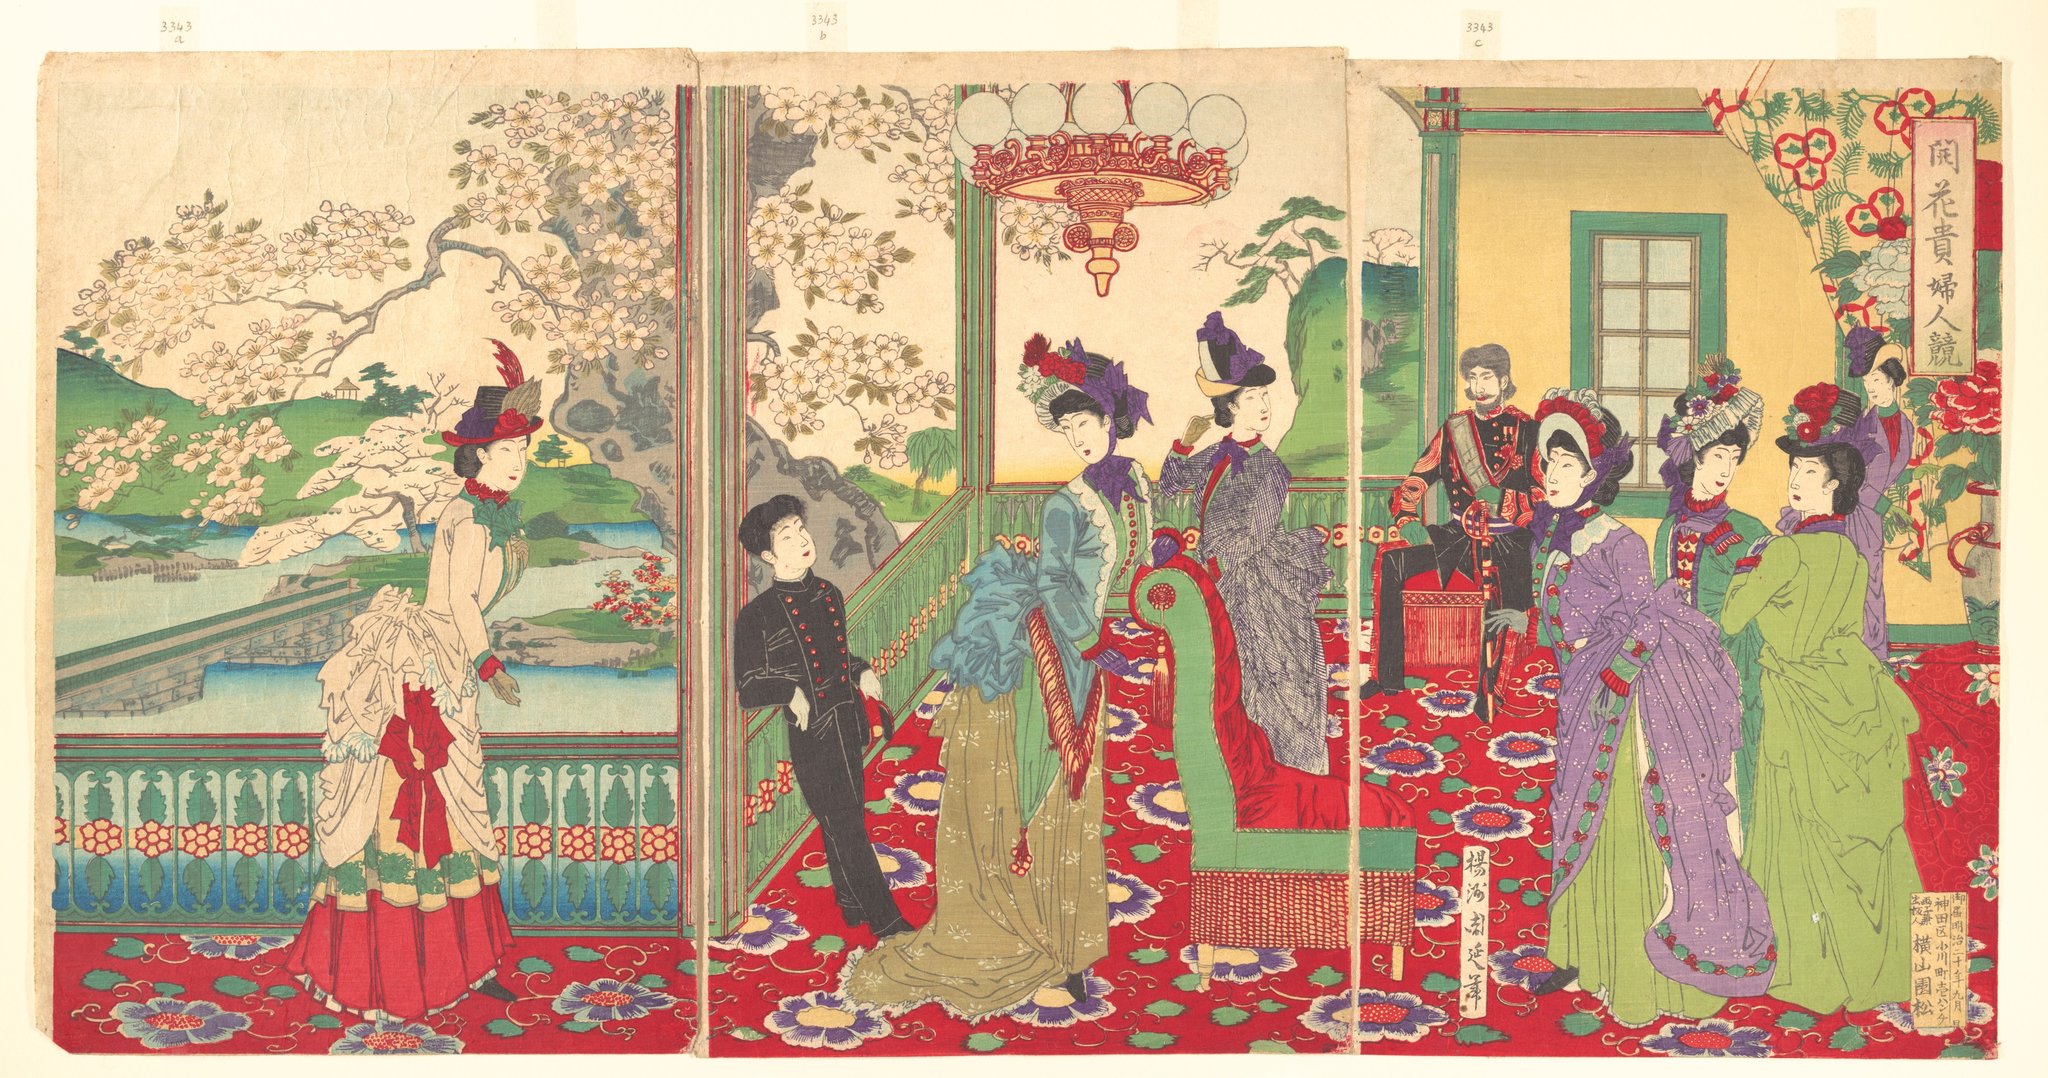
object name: print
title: A Contest of Elegant Ladies among the Cherry Blossoms (Kaika kifujin kisoi)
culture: japanese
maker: yōshū (hashimoto) chikanobu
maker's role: artist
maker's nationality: japanese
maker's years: 1838-1912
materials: ink, paper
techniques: nishiki e, woodblock print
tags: men,women,flowers,trees